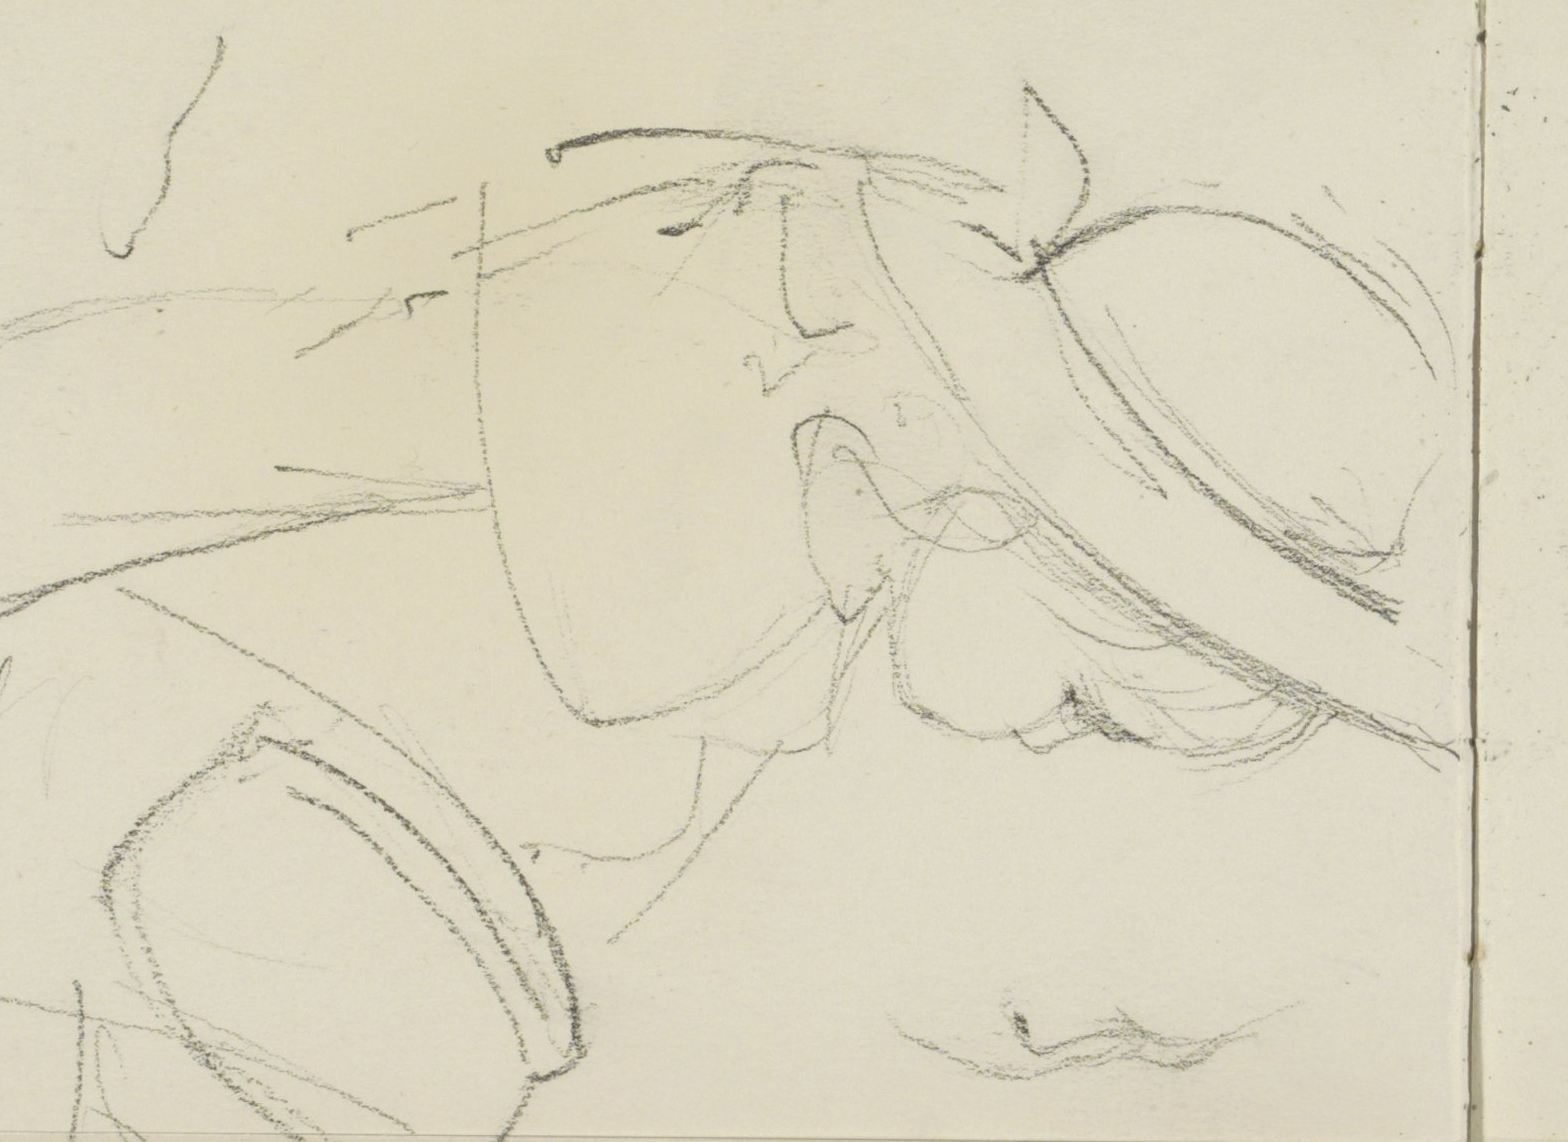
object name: sketchbook leaf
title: Meisje met een hoed met een lint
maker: a.a.l. de grammont-hubrecht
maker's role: draughtsman, painter, print maker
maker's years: 1855-1913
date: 1865-1913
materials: chalk, paper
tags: border, ribbon, braid, girl (child between toddler and youth), head-gear: hat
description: Blad 9 verso uit een schetsboek met 38 bladen.